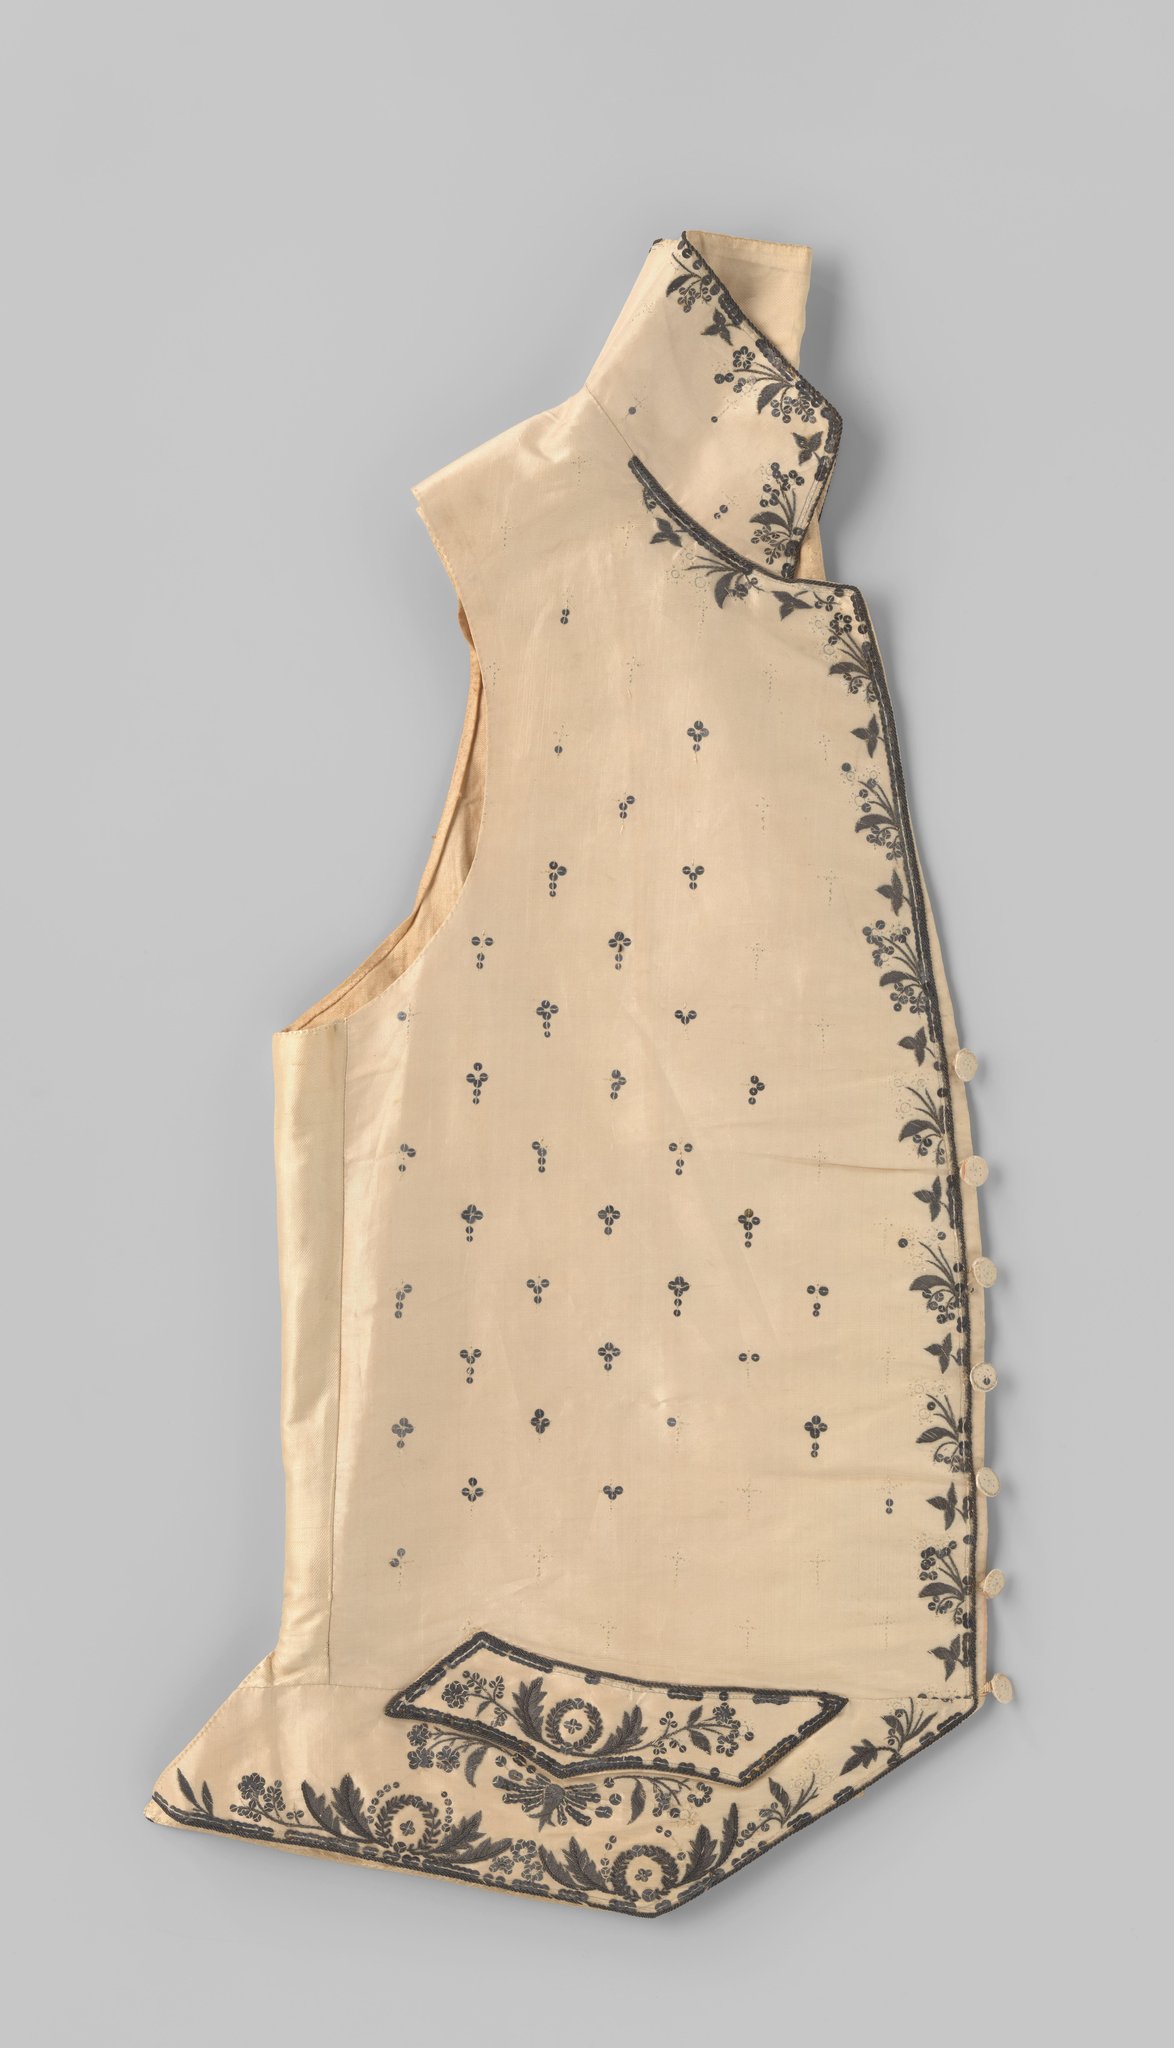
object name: clothing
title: Vest van I.J.A. Gogel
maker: Anonymous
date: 1789-1814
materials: textile, silk, thread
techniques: embroidered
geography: netherlands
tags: vught, overveen, staatsman, intendant-generaal van financien, secretaris van staat voor financien, minister van financiën, izaak jean alexandre gogel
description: Uniform of Isaac Gogel. Netherlands, c. 1800-1821. Robe, jacket and breeches are typical of early 19th-century fashions. Medals were pinned on the robe.